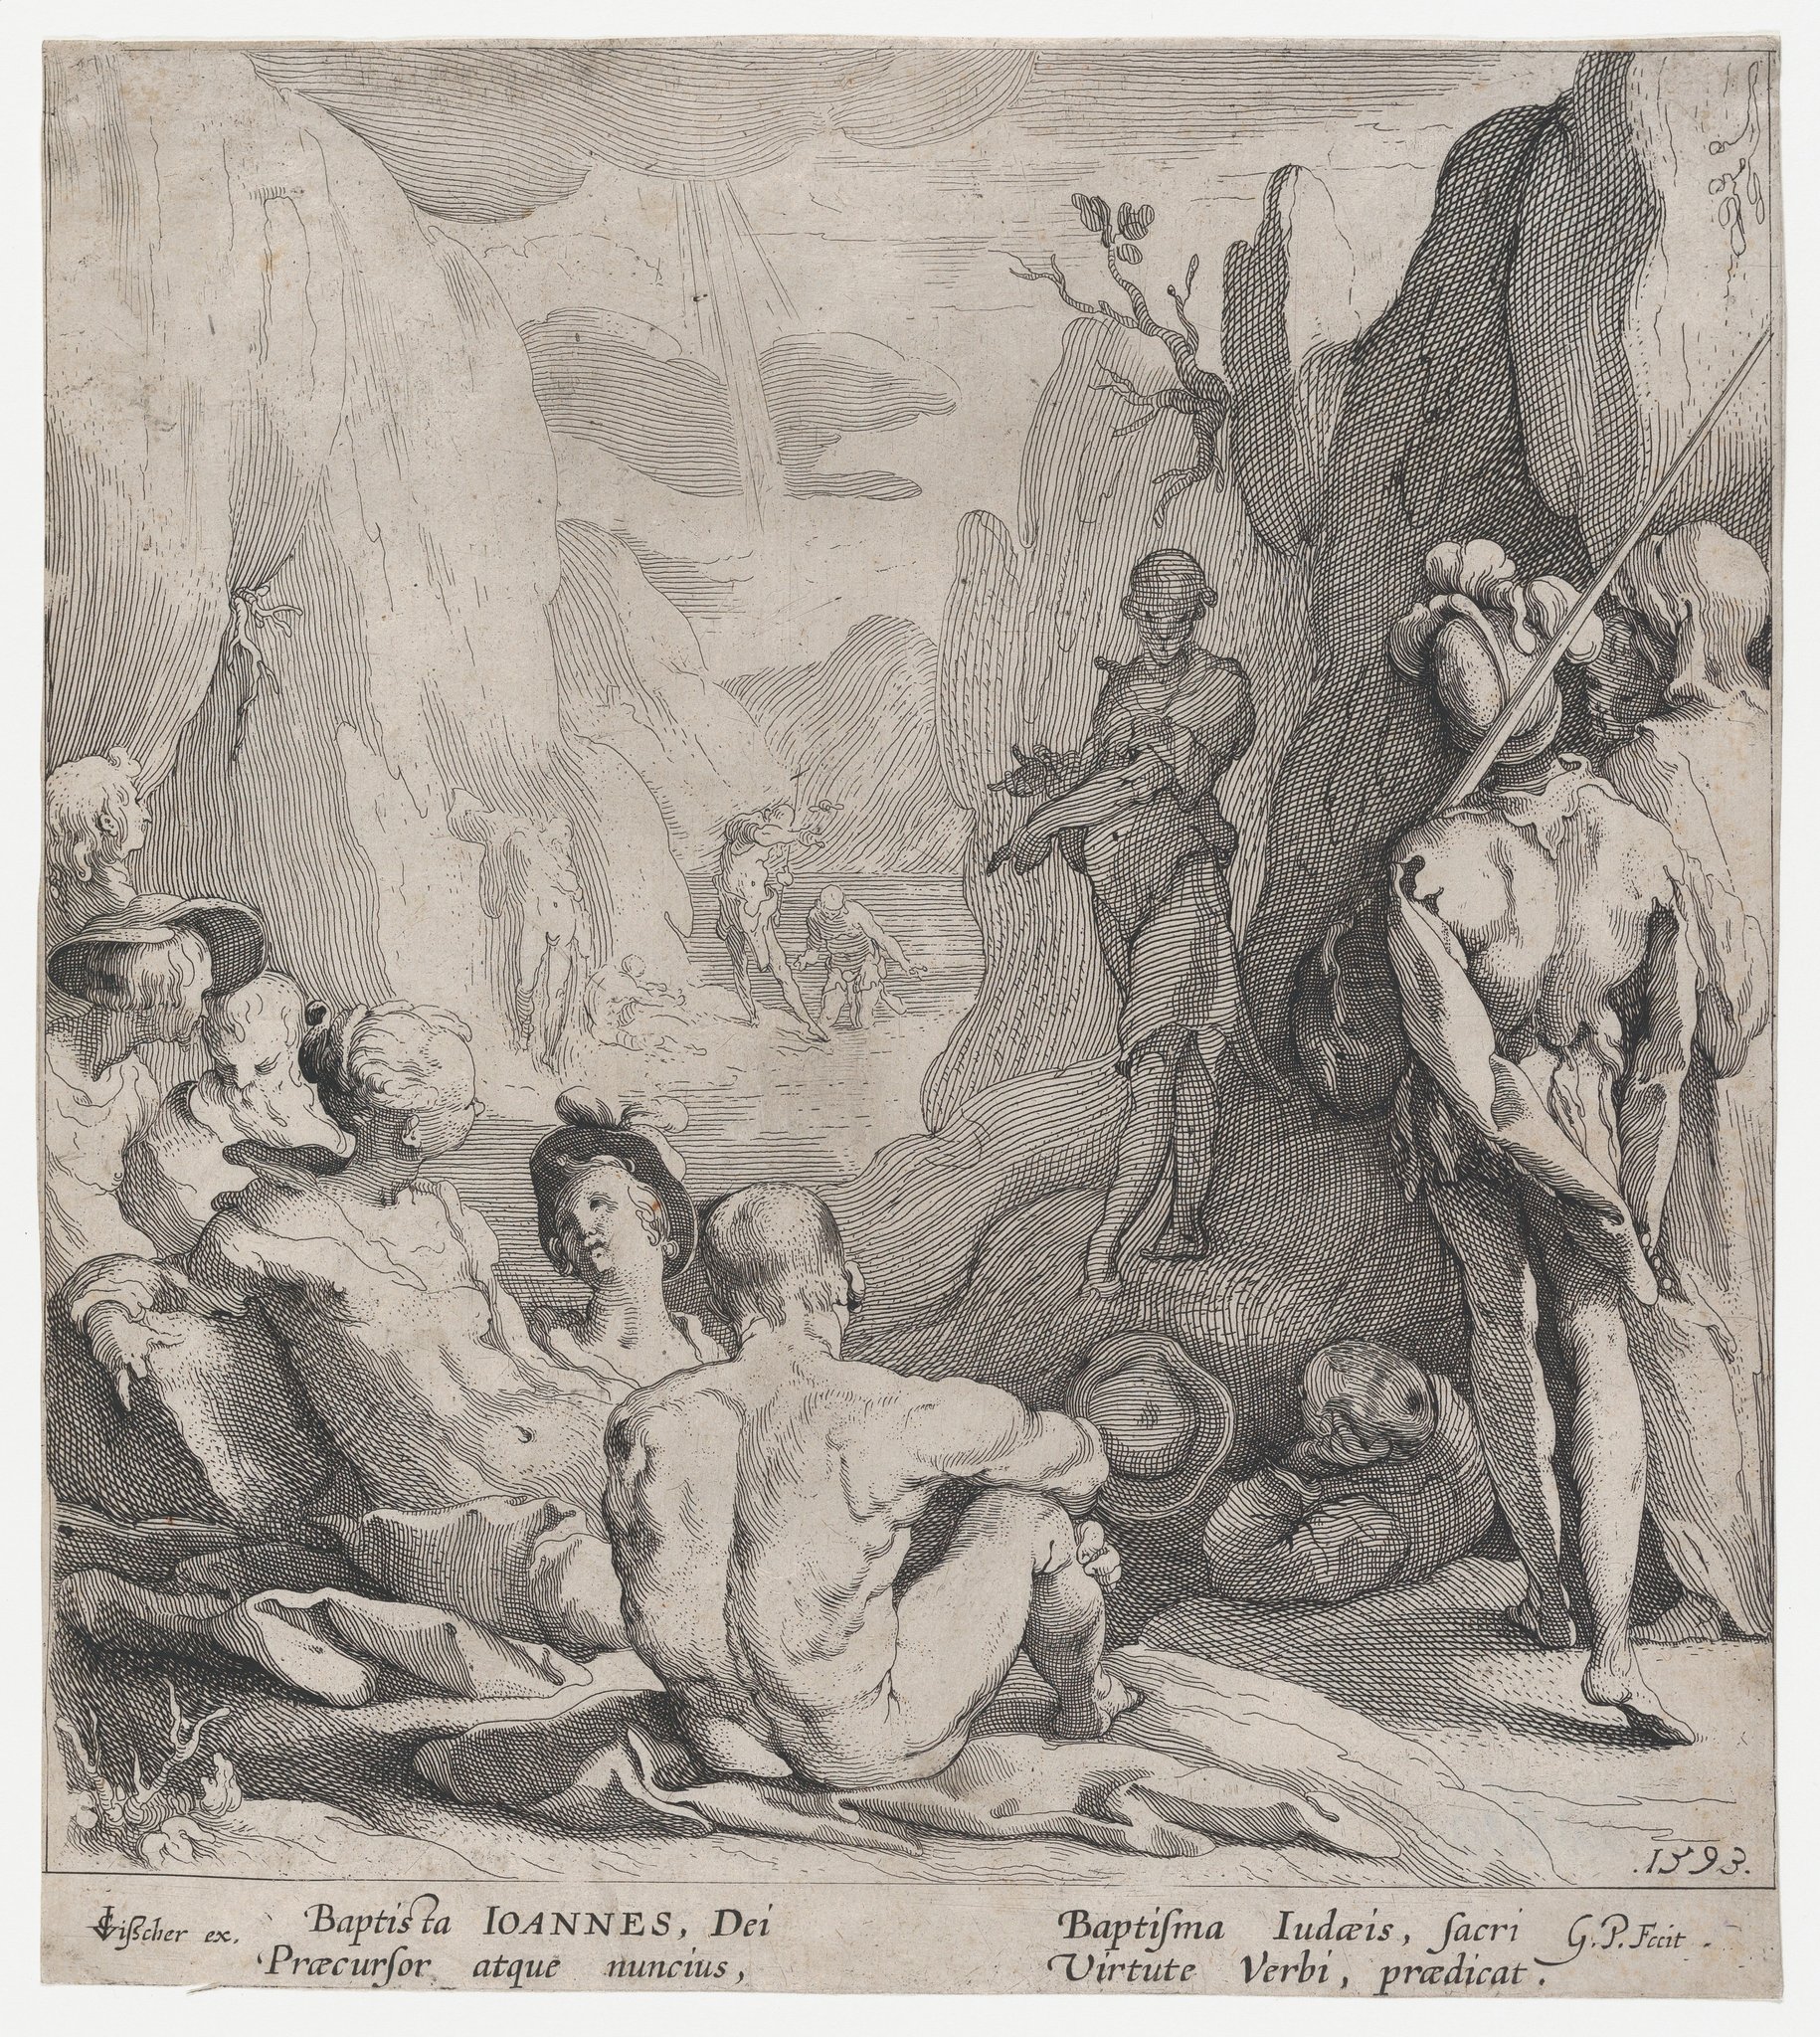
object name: print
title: St. John the Baptist Preaching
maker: gerrit pietersz. sweelink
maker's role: artist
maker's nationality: netherlandish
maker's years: 1566-1612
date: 1593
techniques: etching